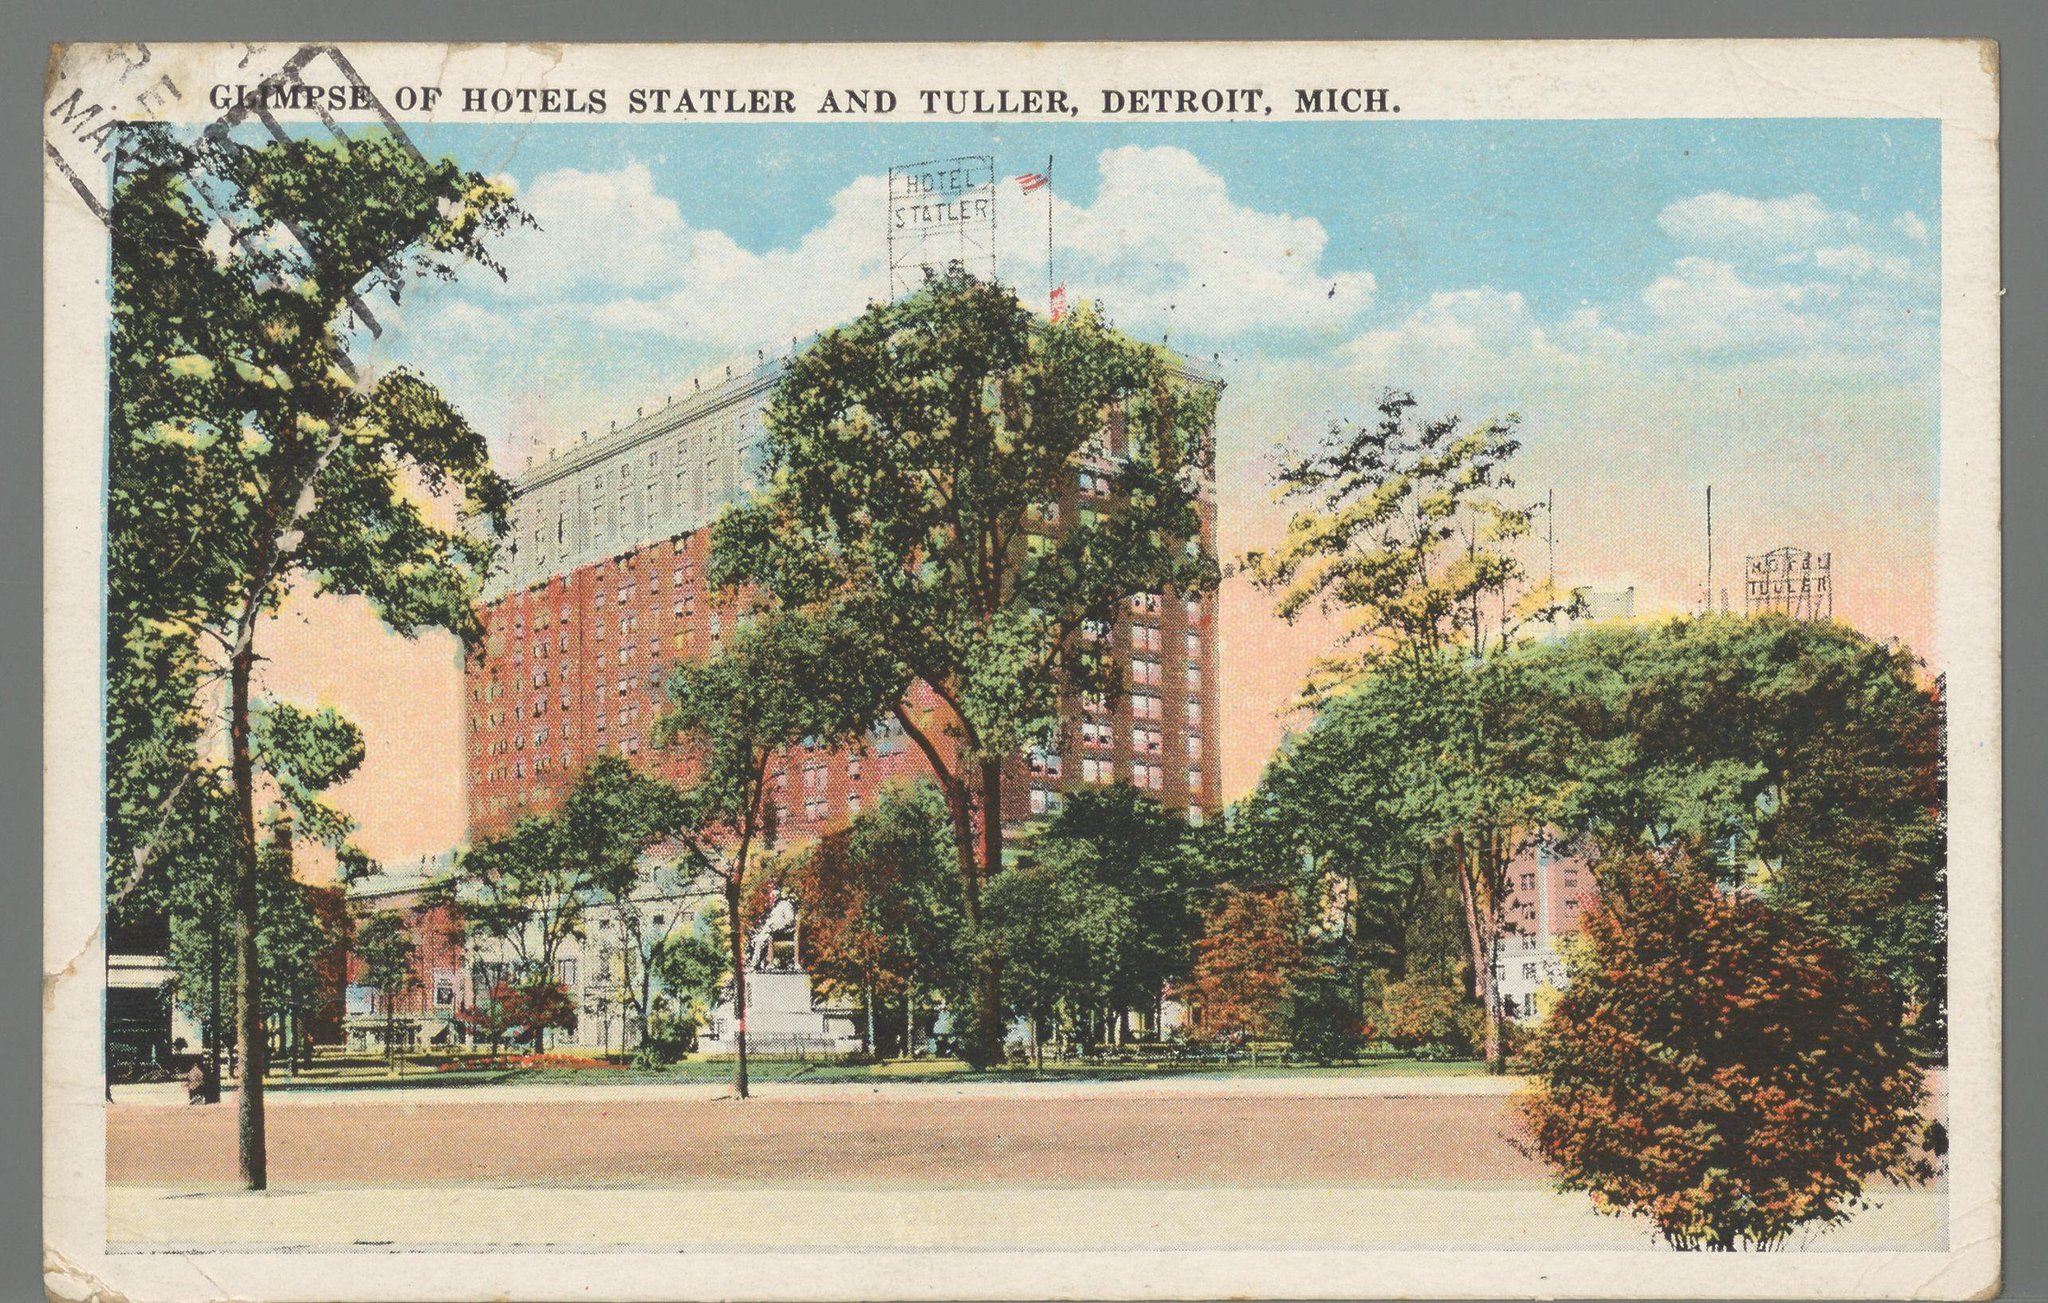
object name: photomechanical print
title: Glimpse of Hotels Statler and Tuller, Detroit, Mich.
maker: Anonymous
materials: cardboard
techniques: lithograph, writing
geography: detroit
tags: hotel, hostelry, inn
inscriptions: poststempel, verso, gestempeld